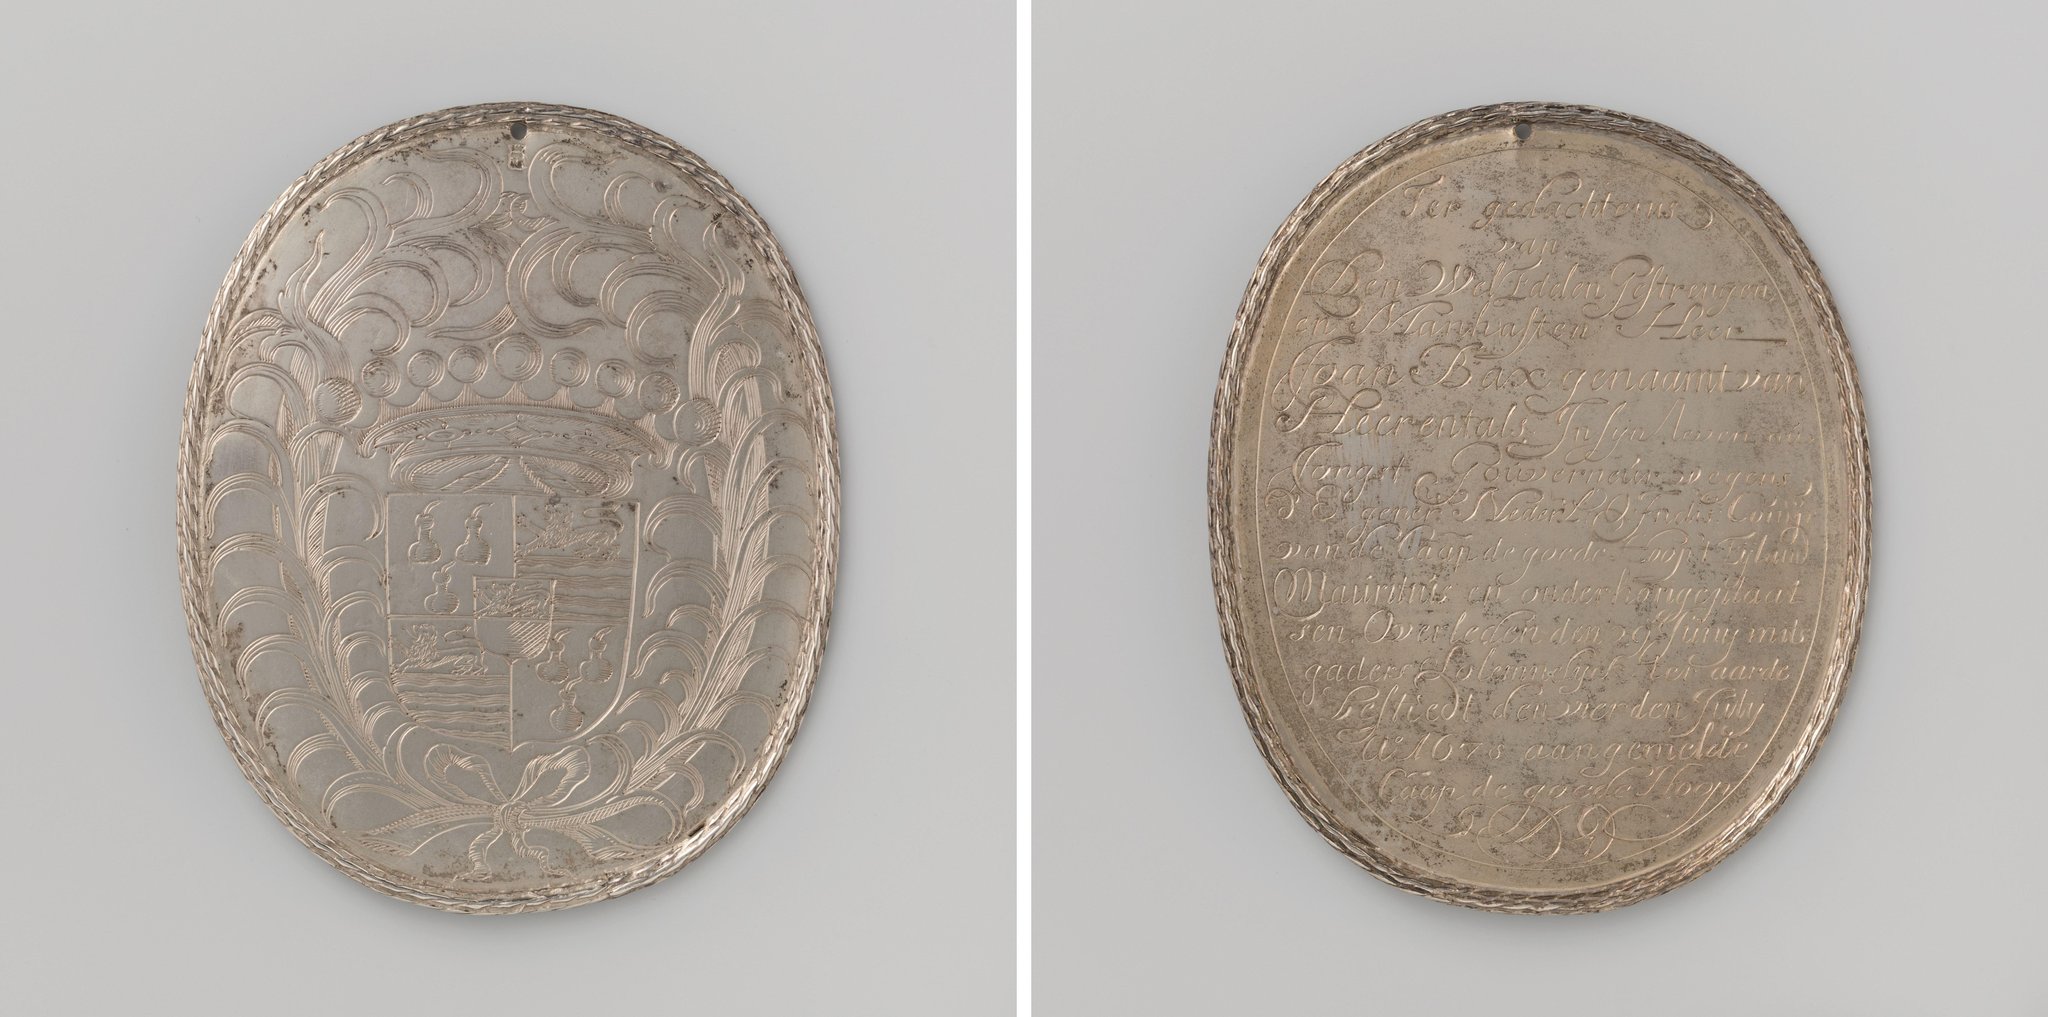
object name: family medal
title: Overlijden van Joan Bax, genaamd van Heerentals, gouverneur van Kaap de Goede Hoop en Mauritius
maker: Anonymous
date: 1678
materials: silver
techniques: striking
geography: dutch east indies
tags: cape of good hope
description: Medal. Silver, in 1678 struck to mark the death of Joan Bax van Heerenthals. Joan Bax van Heerenthals served as governor of the Cape of Good Hope and Mauritius from 1676 until his death in 1678. The VOC had a settlement on the island of Mauritius in the Indian Ocean as well.